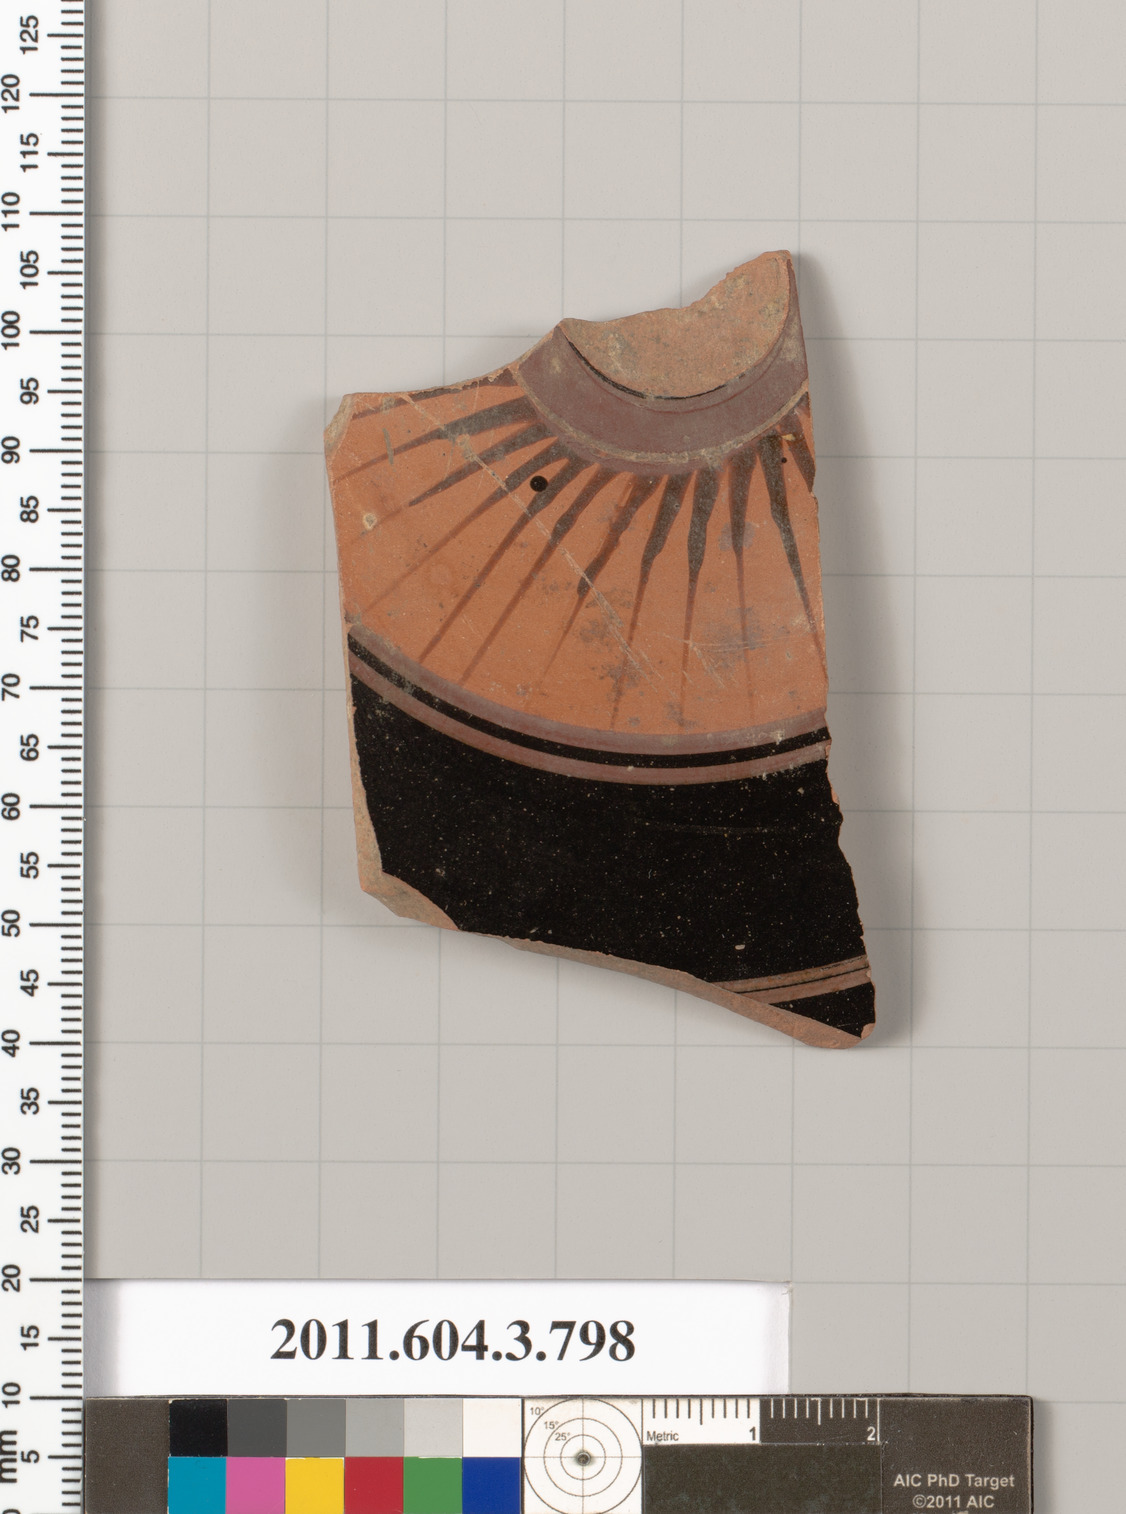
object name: lid fragment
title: Terracotta fragment of a lid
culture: greek, attic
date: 600-501 BCE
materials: terracotta